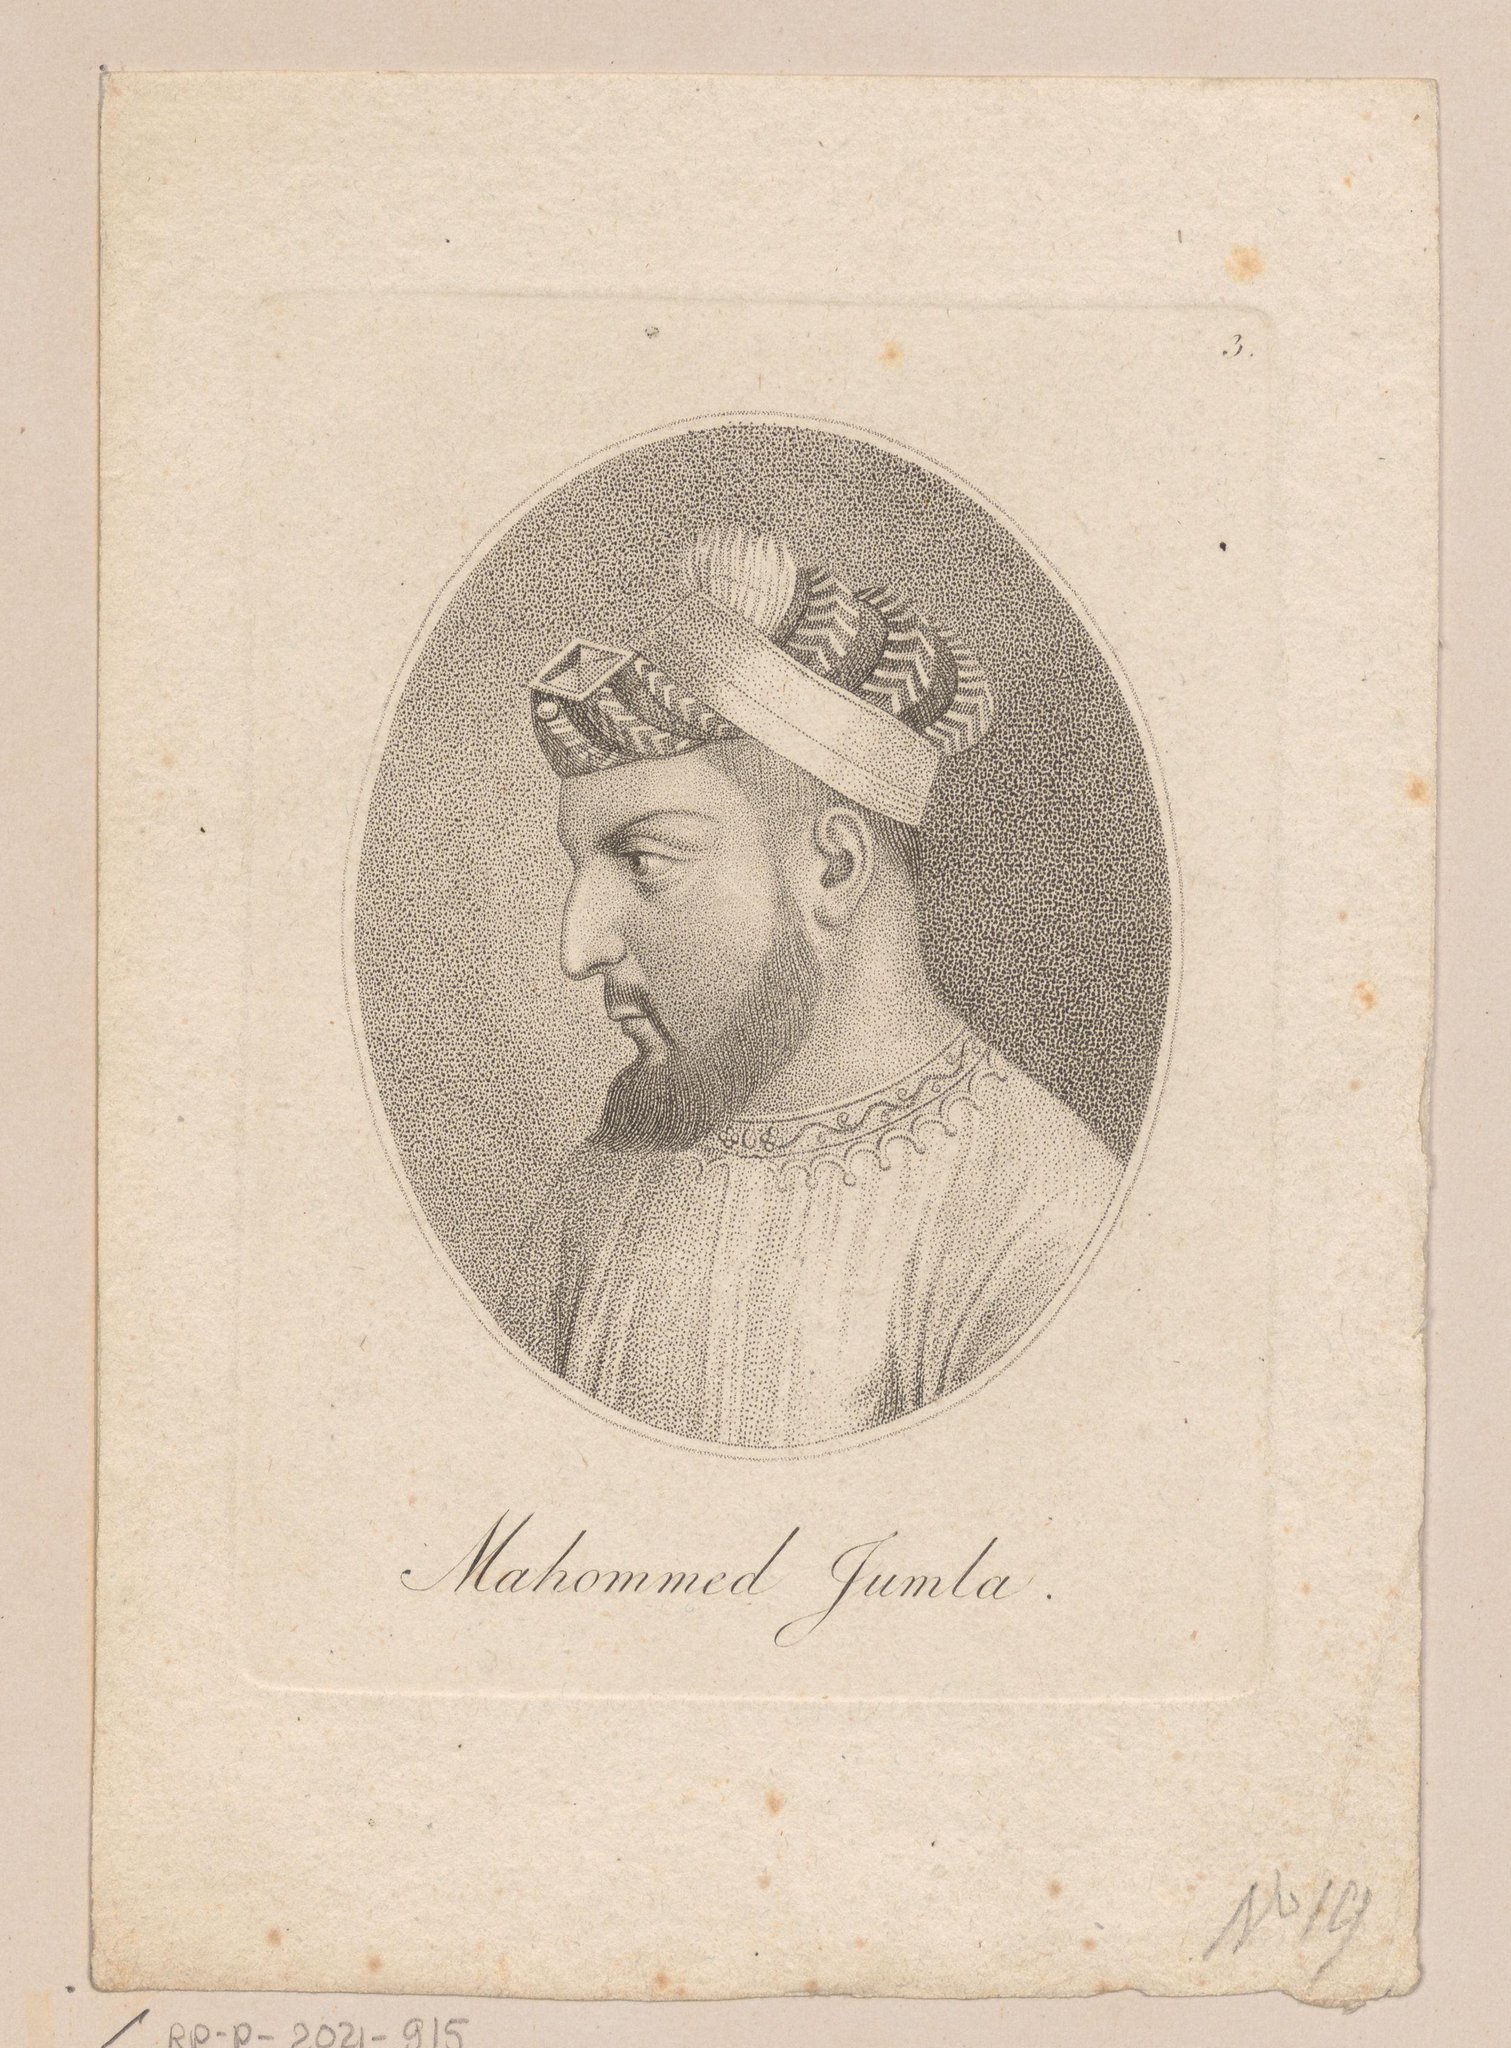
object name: print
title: Portret van meneer Mahommed Jumla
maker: Anonymous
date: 1750-1850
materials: paper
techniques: stippling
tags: historical persons, head-gear: turban, ruler, sovereign